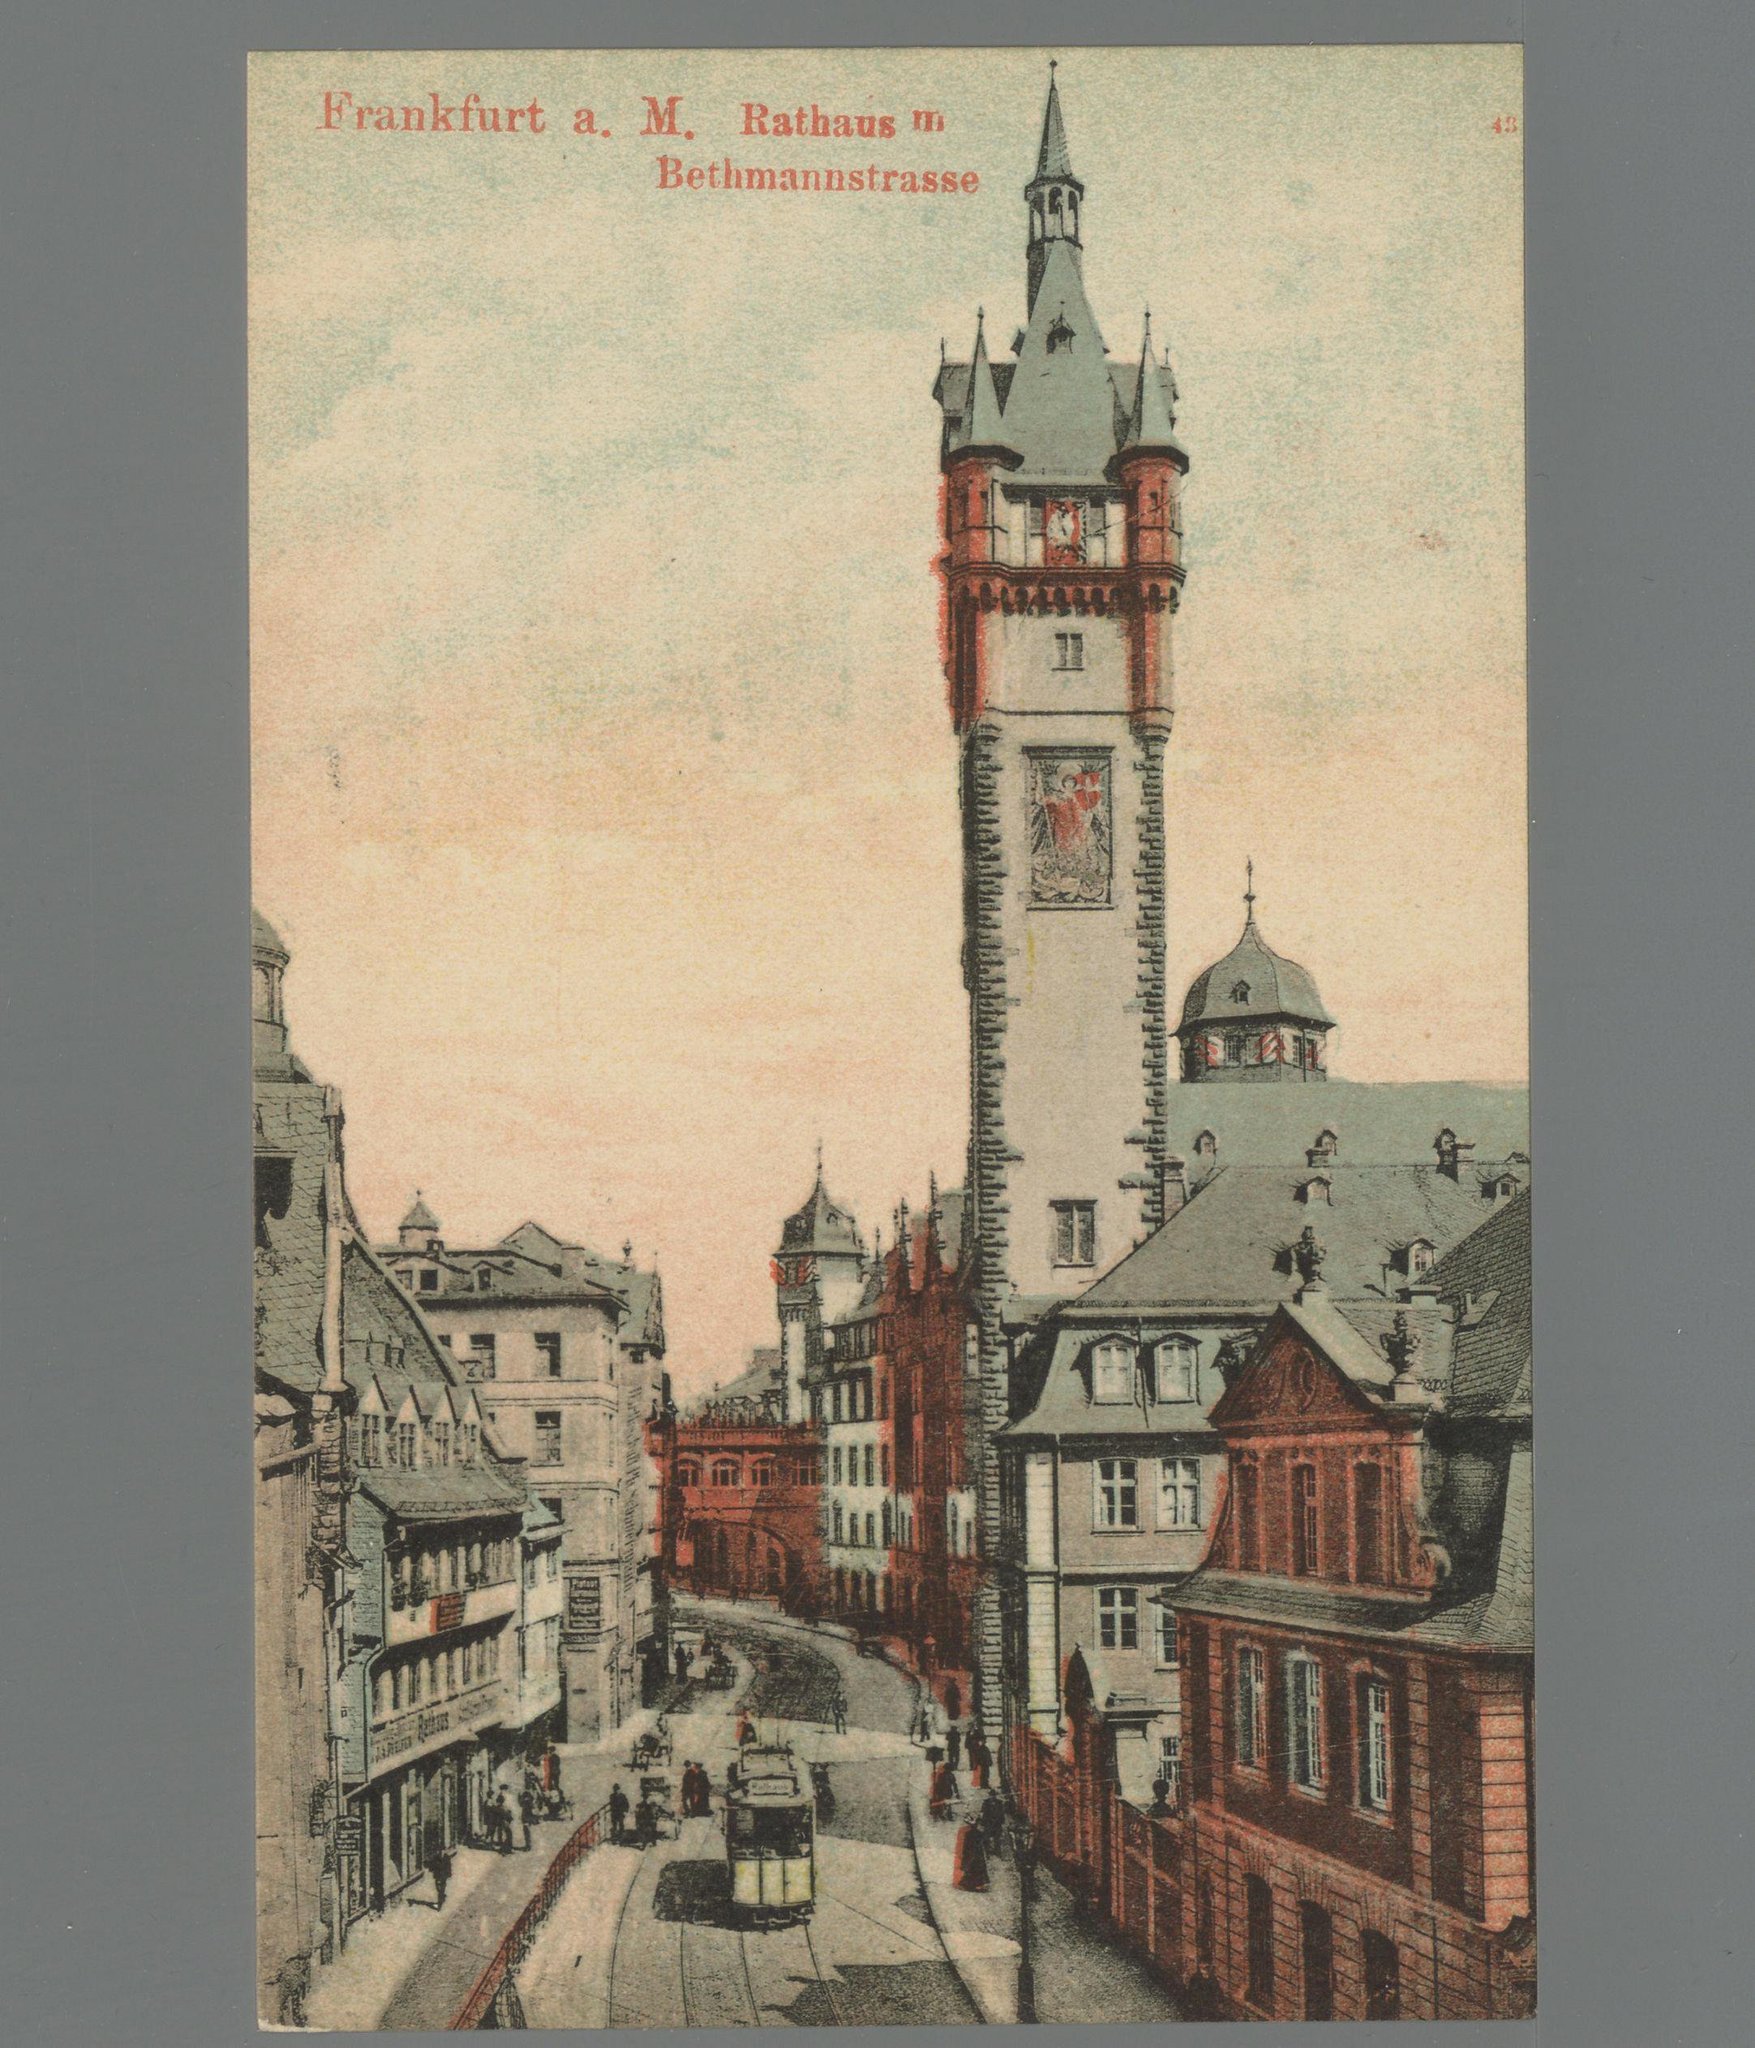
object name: photomechanical print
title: Frankfurt a. M. Rathaus m Bethmannstrasse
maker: Anonymous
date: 1905-1908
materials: cardboard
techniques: photograph, lithograph, writing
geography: frankfurt am main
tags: townhall, street